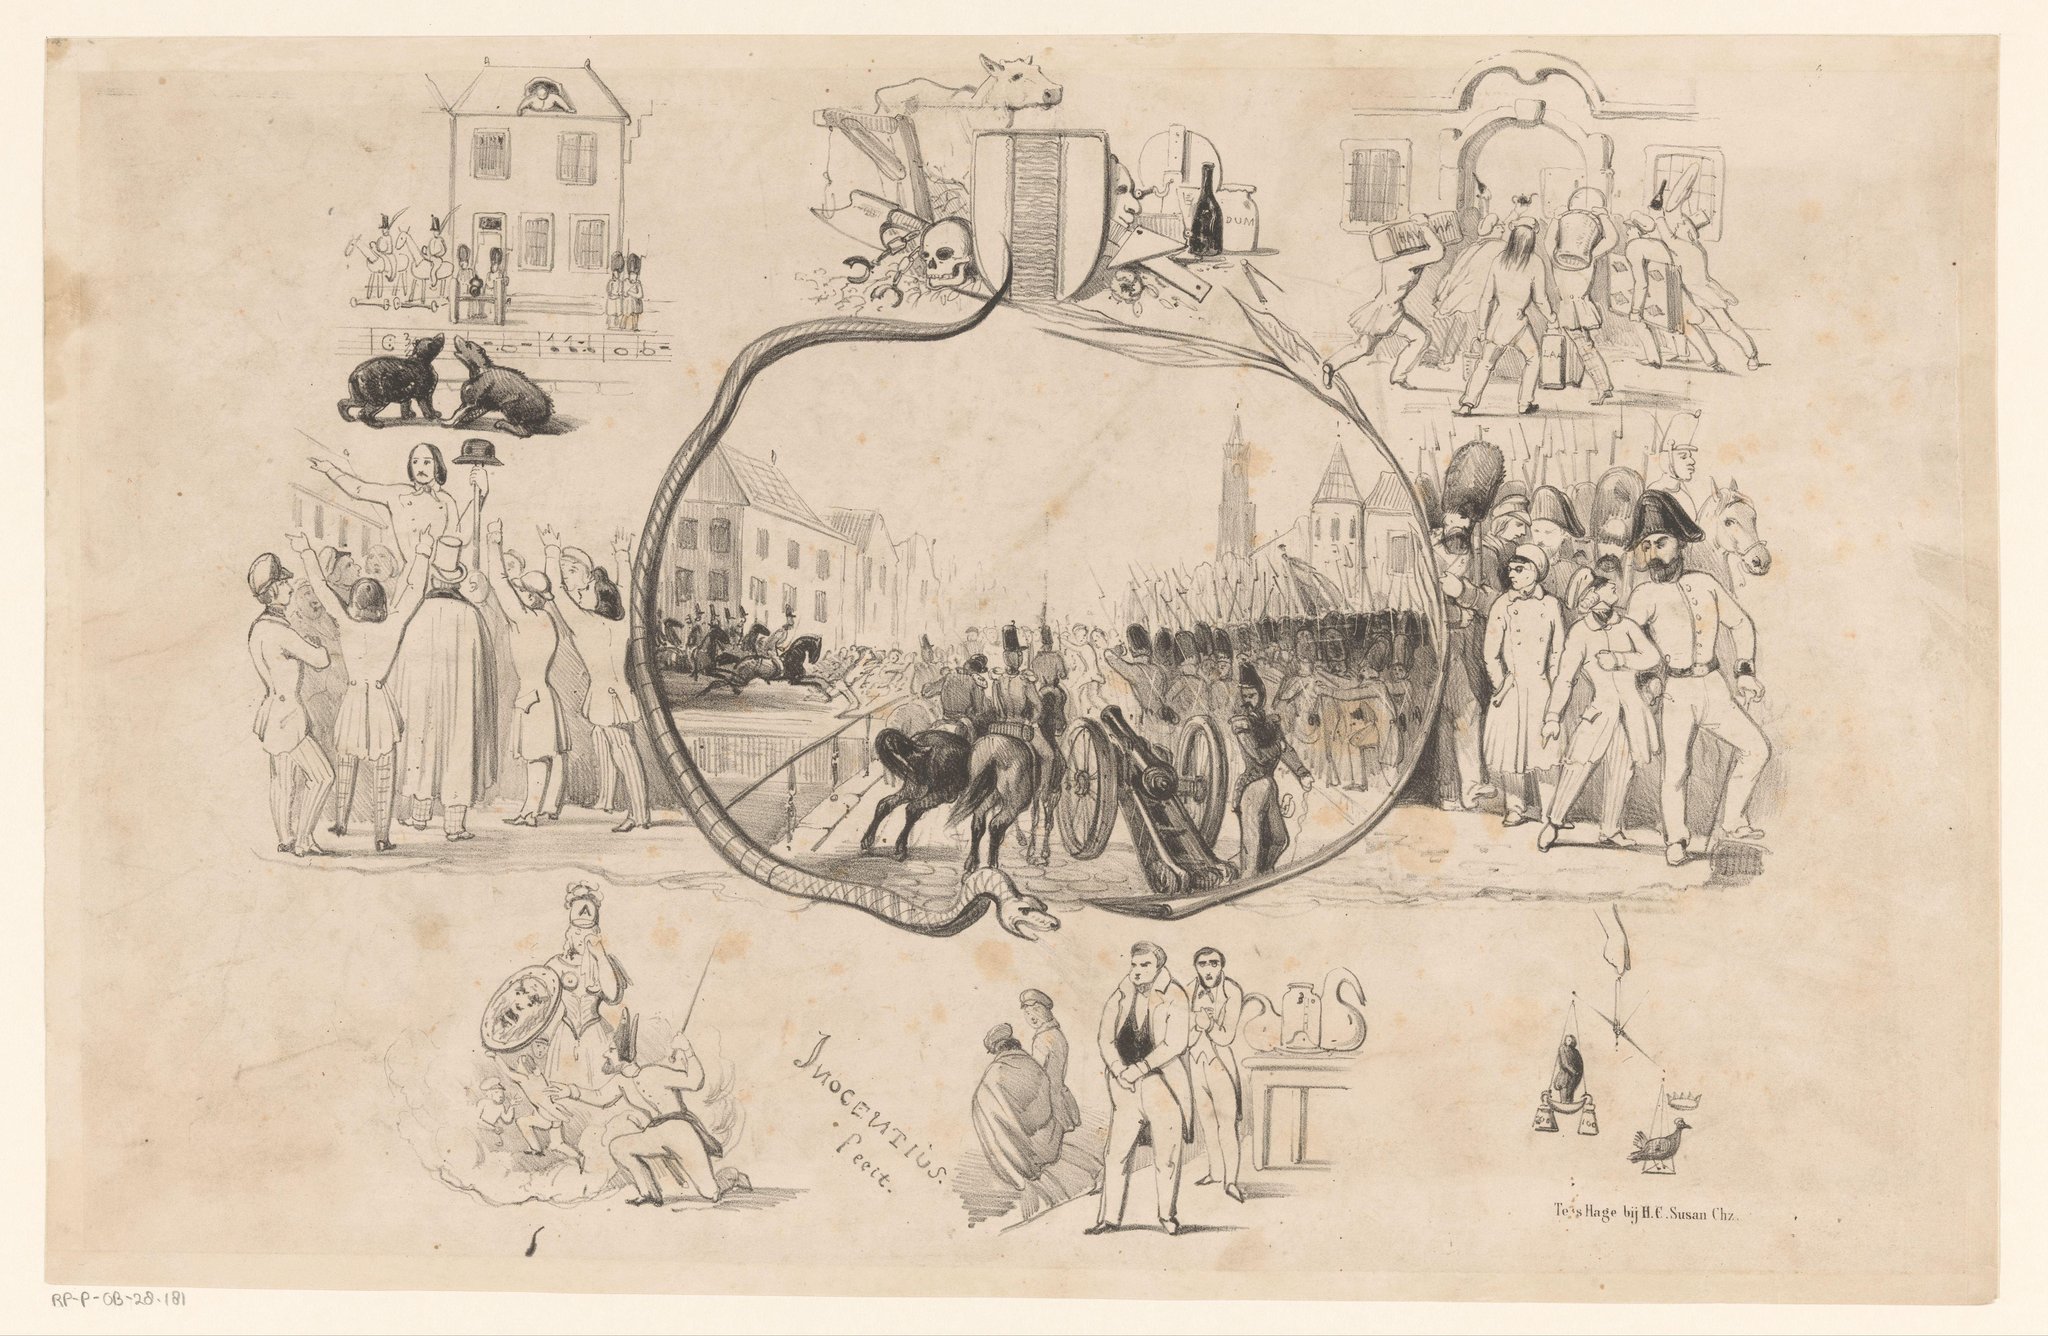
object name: print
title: Spotprent studenten Delft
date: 1843-1849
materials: paper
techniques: lithograph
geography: netherlands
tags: students' riot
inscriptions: collector's mark: Lugt 2228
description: Spotprent over de ongeregeldheden onder de studenten in de stad Delft naar aanleiding van twisten over de aanstelling van de heer Carel Frederik Donnadieu in plaats van de heer Petrus Jacobus Kipp als hoogleraar scheikunde aan de Koninklijke Akademie.